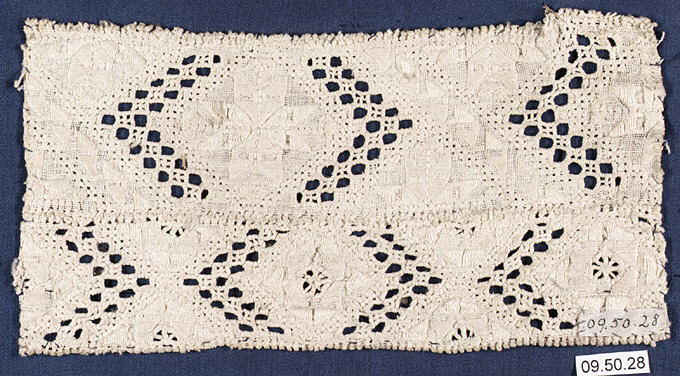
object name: fragment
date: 1501-1600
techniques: embroidery